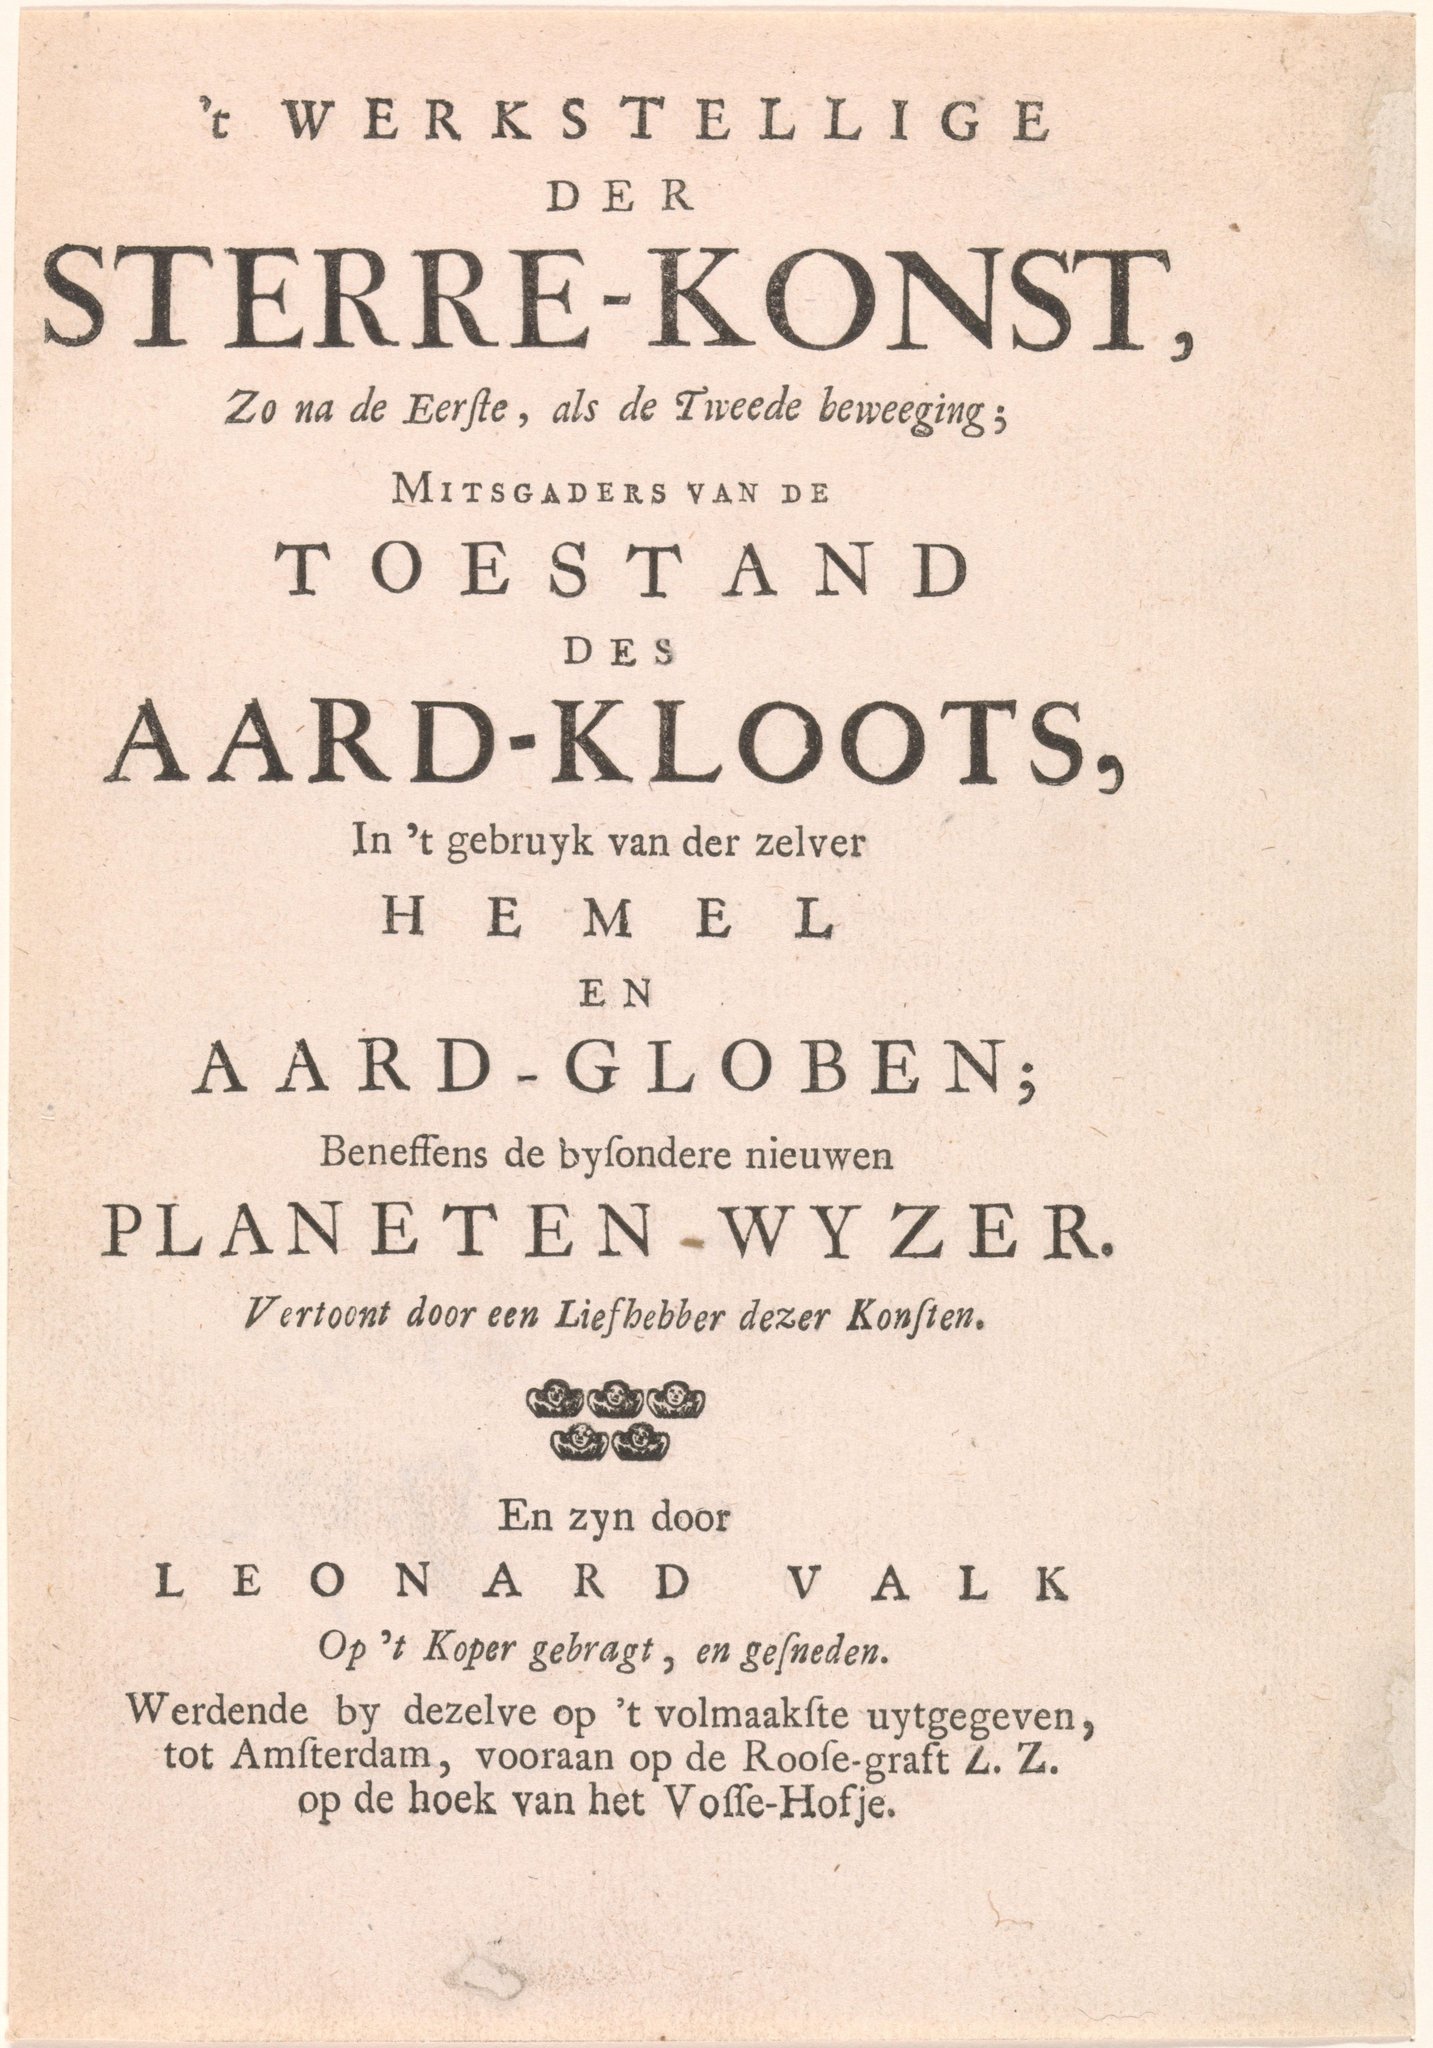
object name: titelblad, titelpagina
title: Titelpagina voor: 't Werkstellige der sterre-konst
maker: leonardus valck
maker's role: print maker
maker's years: 1675-1755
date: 1706-1730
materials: paper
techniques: letterpress printing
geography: amsterdam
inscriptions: collector's mark: Lugt 2228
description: Titelpagina voor: 't Werkstellige der sterre-konst, zo na de eerste, als de tweede beweeging. Mitsgaders van de toestand des aard-kloots. Amsterdam: L. Valk, tussen 1706 en 1730.